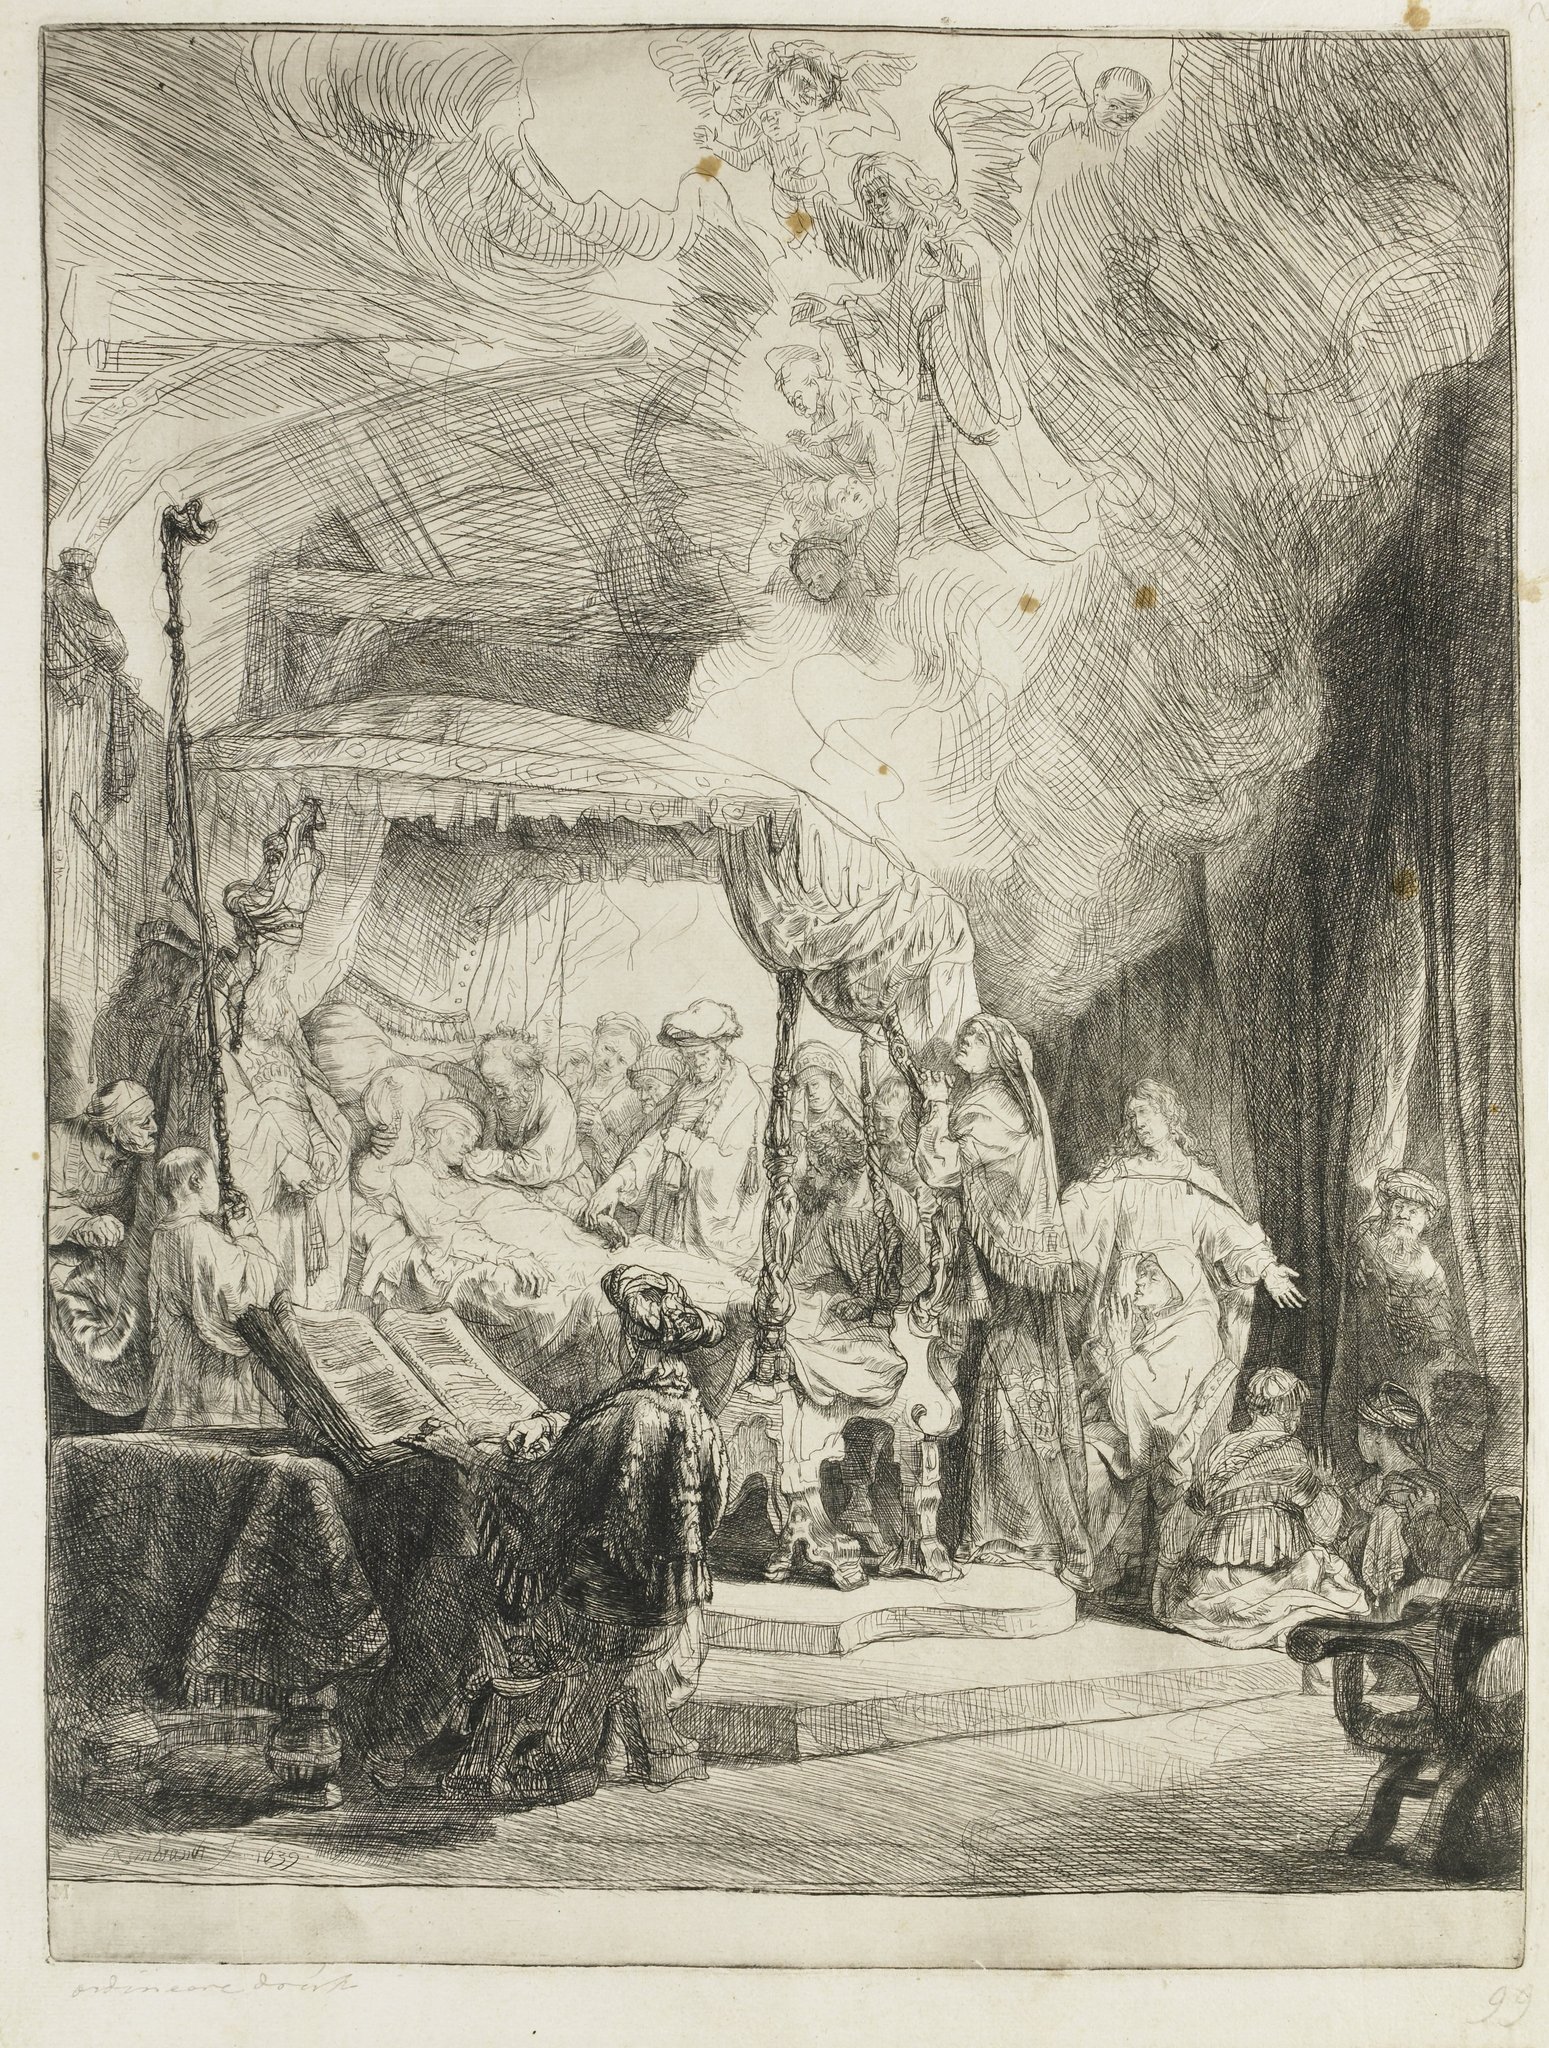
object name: print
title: The death of the Virgin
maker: rembrandt van rijn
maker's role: draughtsman, painter, print maker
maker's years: 1606-1669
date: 1639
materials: paper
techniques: drypoint, etching, intaglio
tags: the dormition: mary on her deathbed; the apostles are gathered around her (john the evangelist may be shown sleeping or dreaming)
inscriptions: collector's mark: ‘M’ Lugt 1841 of 1842, collector's mark: Lugt 240, signature and date: ‘Rembrandt f 1639’